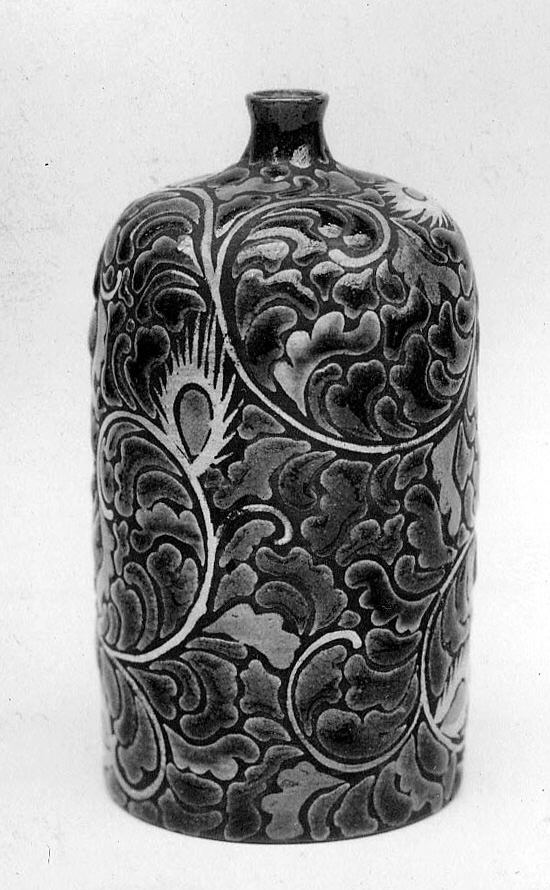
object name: wine bottle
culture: japanese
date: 1780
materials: enamel, faience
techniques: relief